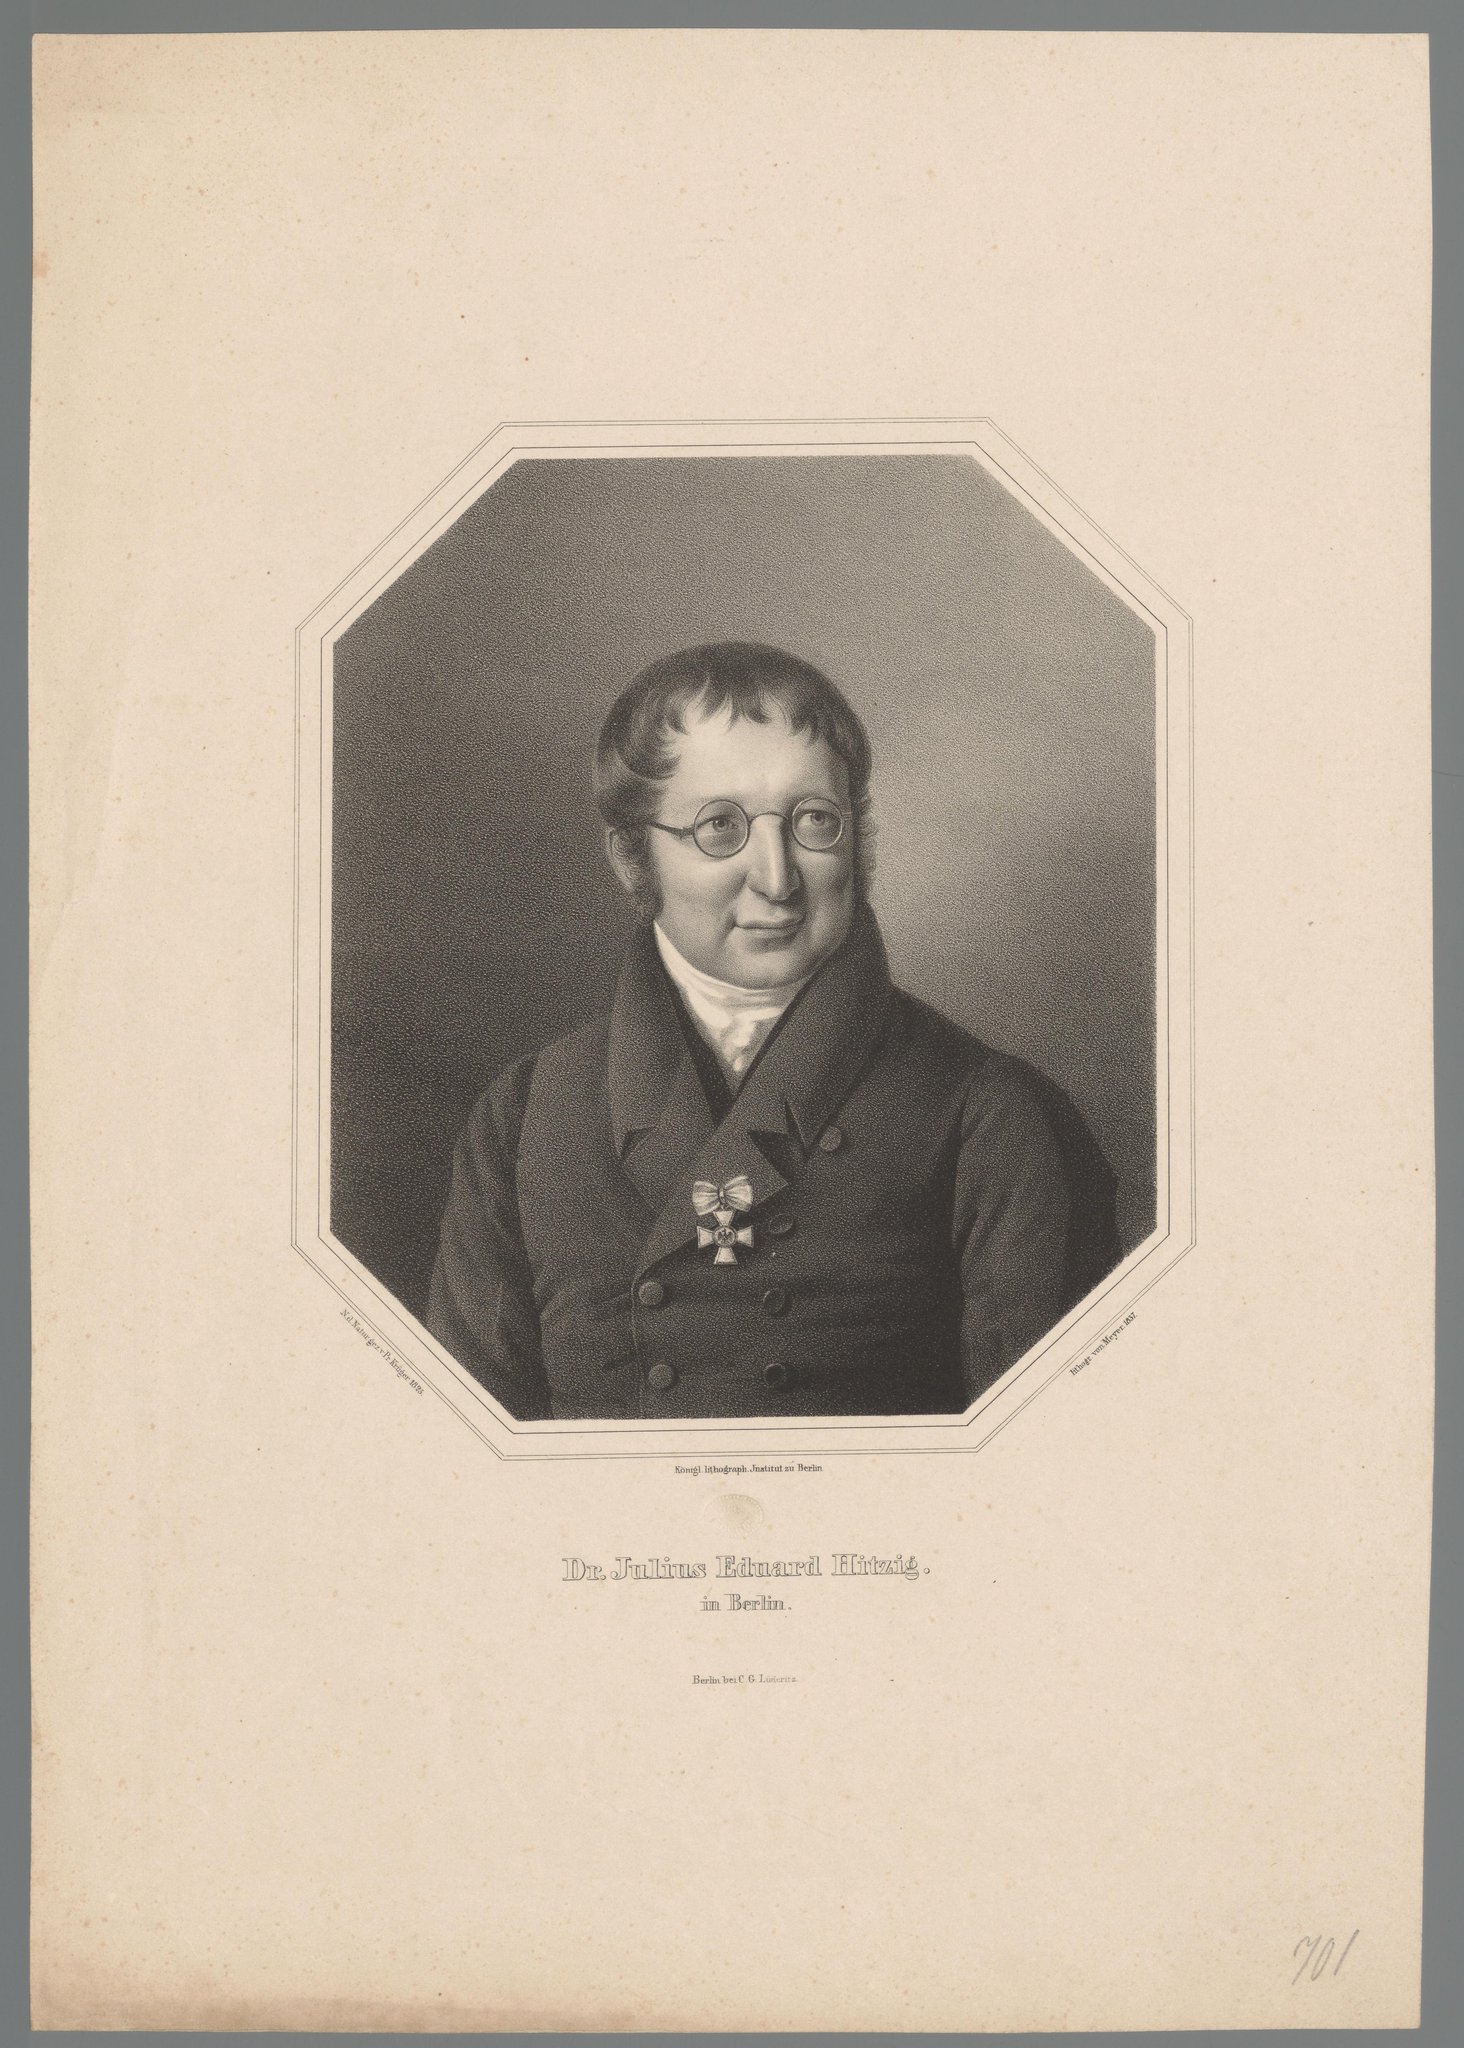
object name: print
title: Dr. Julius Eduard Hitzig, in Berlin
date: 1837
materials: paper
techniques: lithograph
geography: berlin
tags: berlin, publisher, eyeglasses, spectacles, adult man, historical persons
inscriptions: check stamp: ‘C.G. Lüderitz’, collector's mark: Lugt 2228